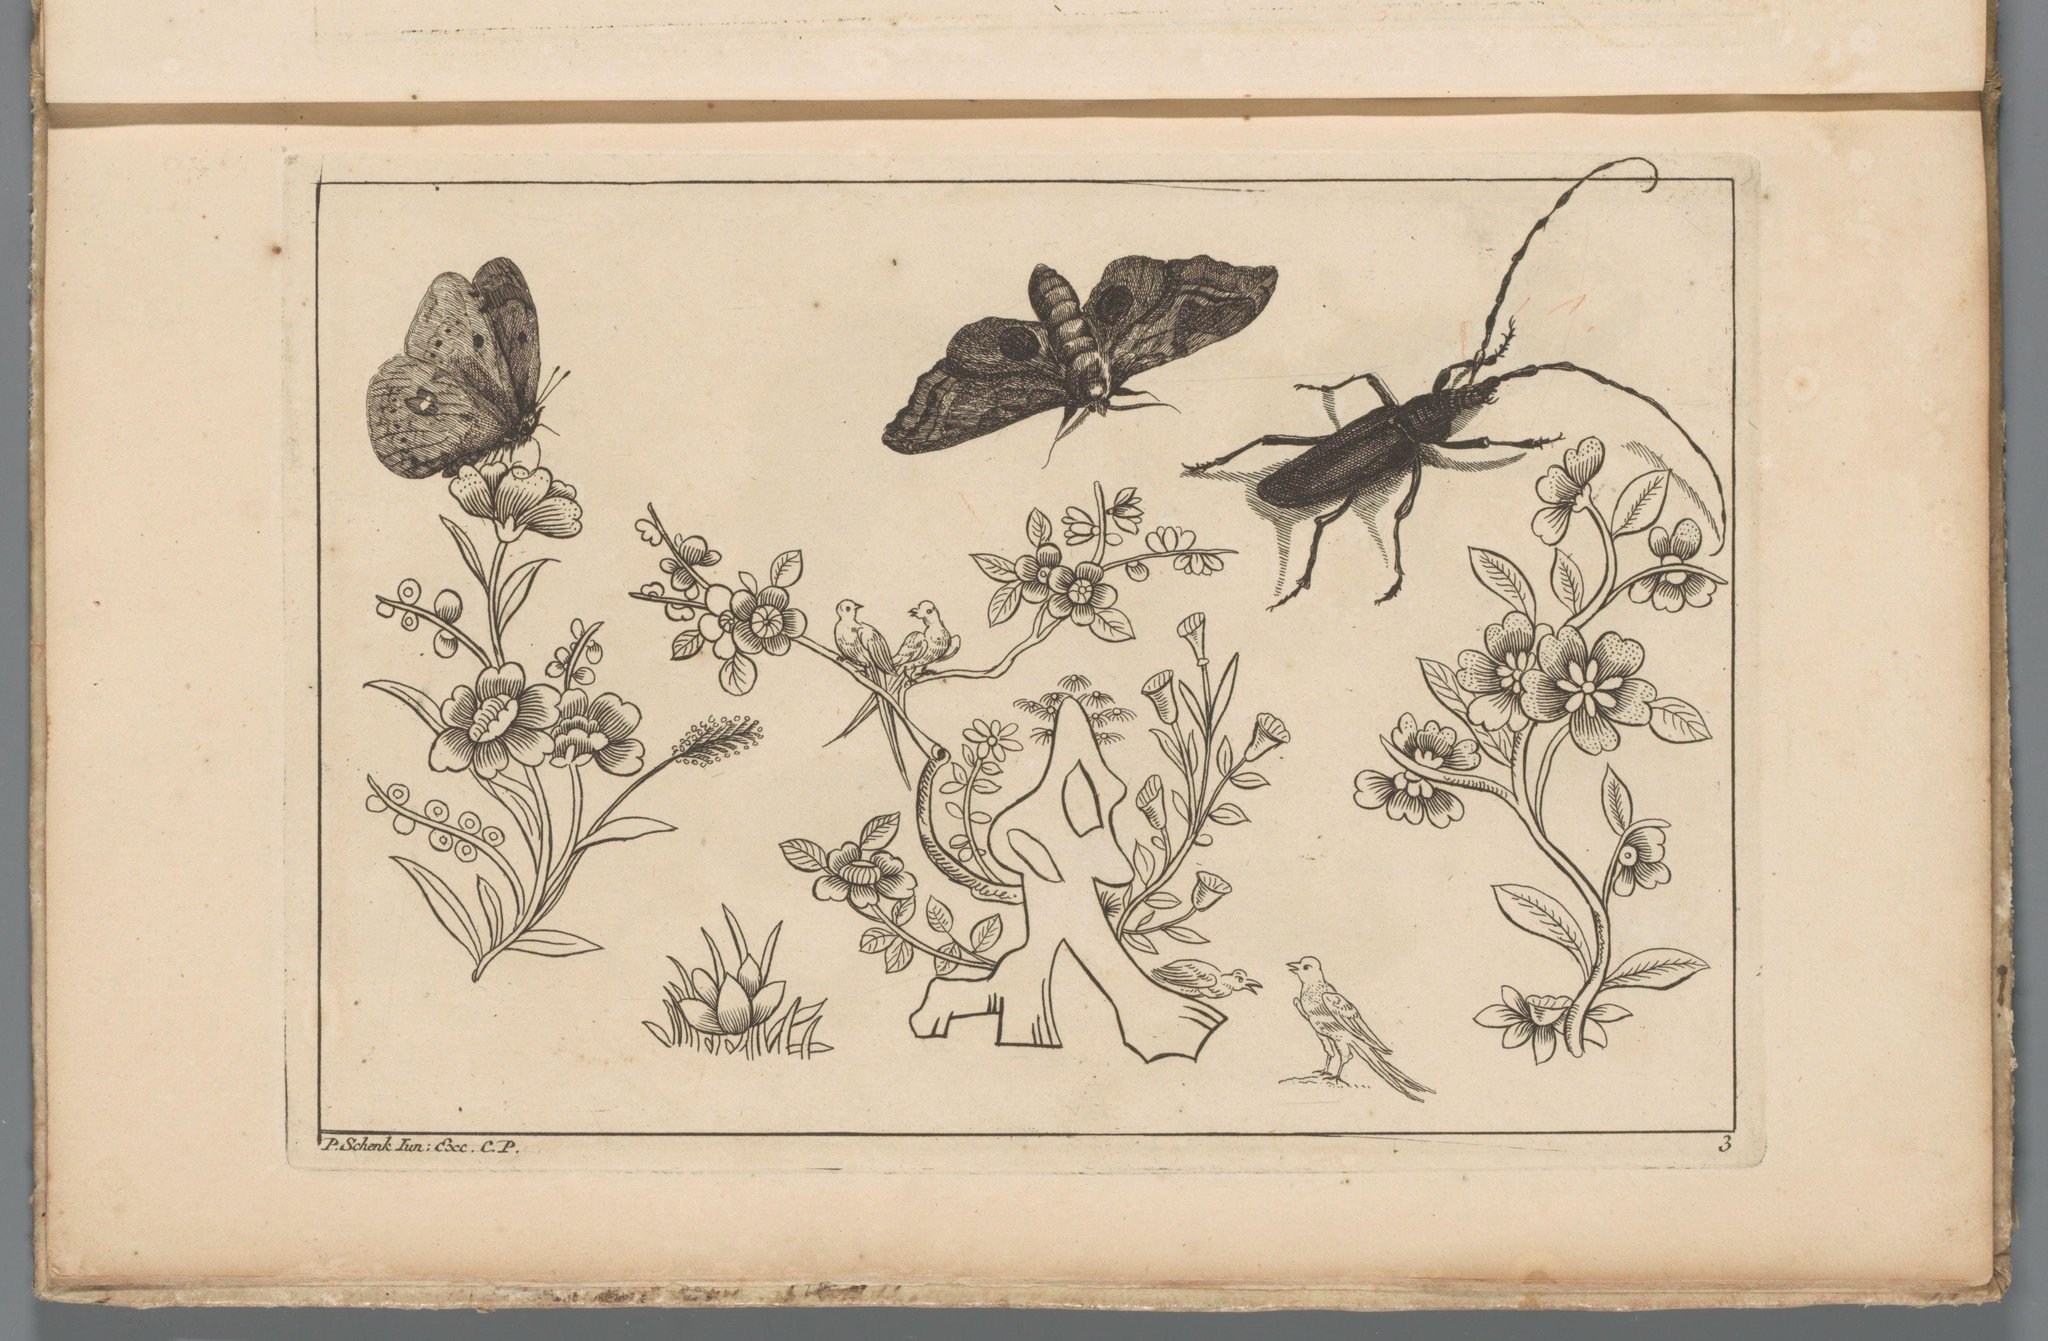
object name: album leaf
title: Drie bloementakken met vogels, vlinders en een insect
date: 1727-1775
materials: paper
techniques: etching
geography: amsterdam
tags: flowers, chinese, insects: butterfly, insects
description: Drie bloementakken met vogels, vlinders en een insect met zes poten en twee voelsprieten. Prent maakt deel uit van een album.